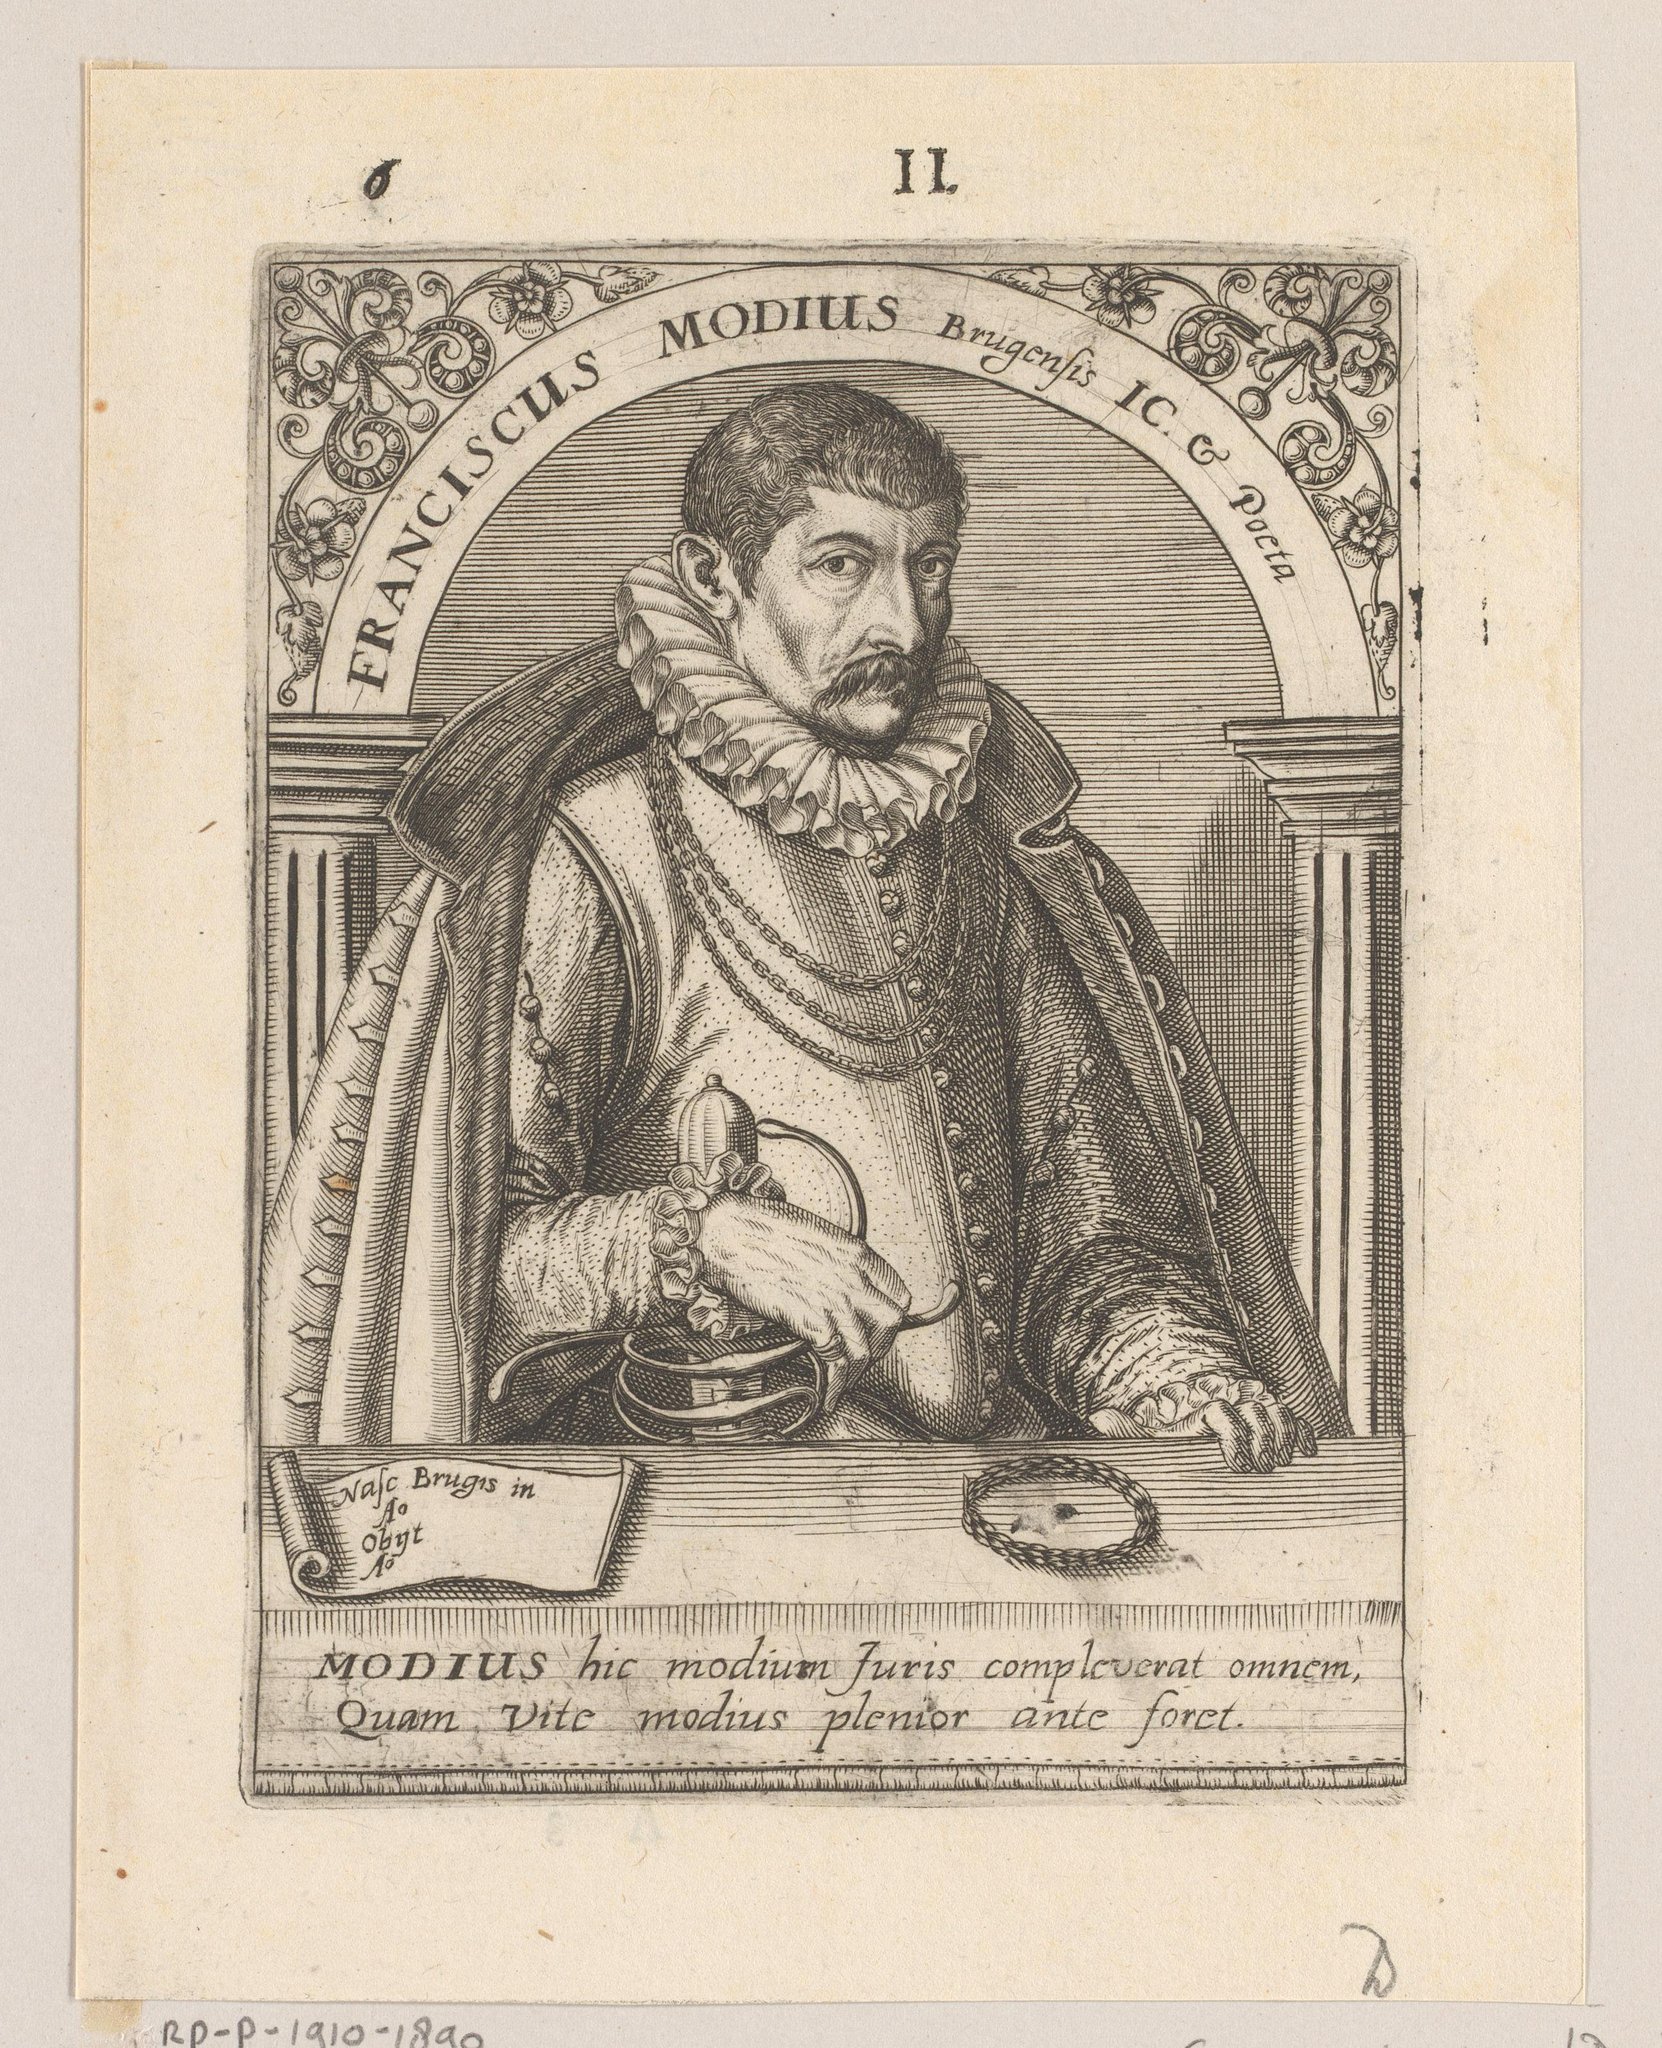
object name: print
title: Franciscus Modius Brugensis IC. poeta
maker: jean jacques boissard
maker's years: 1528-1598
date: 1599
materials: paper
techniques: engraving, letterpress printing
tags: bruges, franciscus modius, historical persons, portrait of a writer, writer, poet, author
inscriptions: collector's mark: Lugt 2228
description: Prent uit: Boissard, Jean Jacques. Icones quinquaginta virorum illustrium doctrina & eruditione praestantium ad vivum effictae. 4 dln. Frankfurt am Main: s.n., 1597-1599, dl. 4, p. 6. Mogelijk ook gebruikt in latere edities. Latere staat van prent verschenen in: Boissard, Jean Jacques. Bibliotheca chalcographica. 8 dln. Frankfurt am Main: Johannes Ammon, 1650-1652. Ook gebruikt in latere edities.